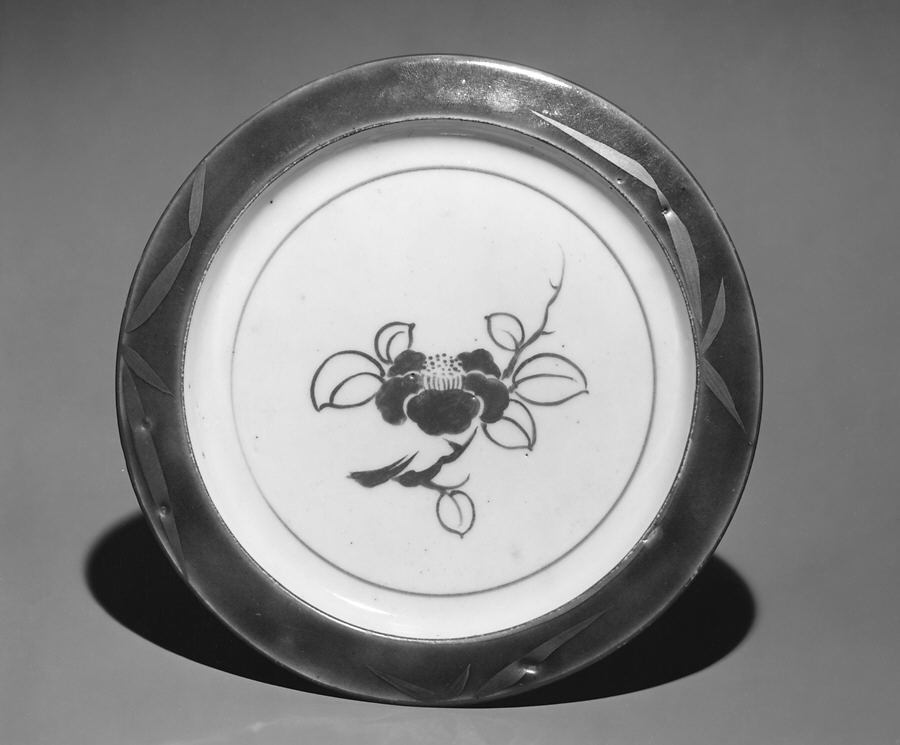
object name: dish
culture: japanese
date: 1615-1868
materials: enamel, porcelain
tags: flowers